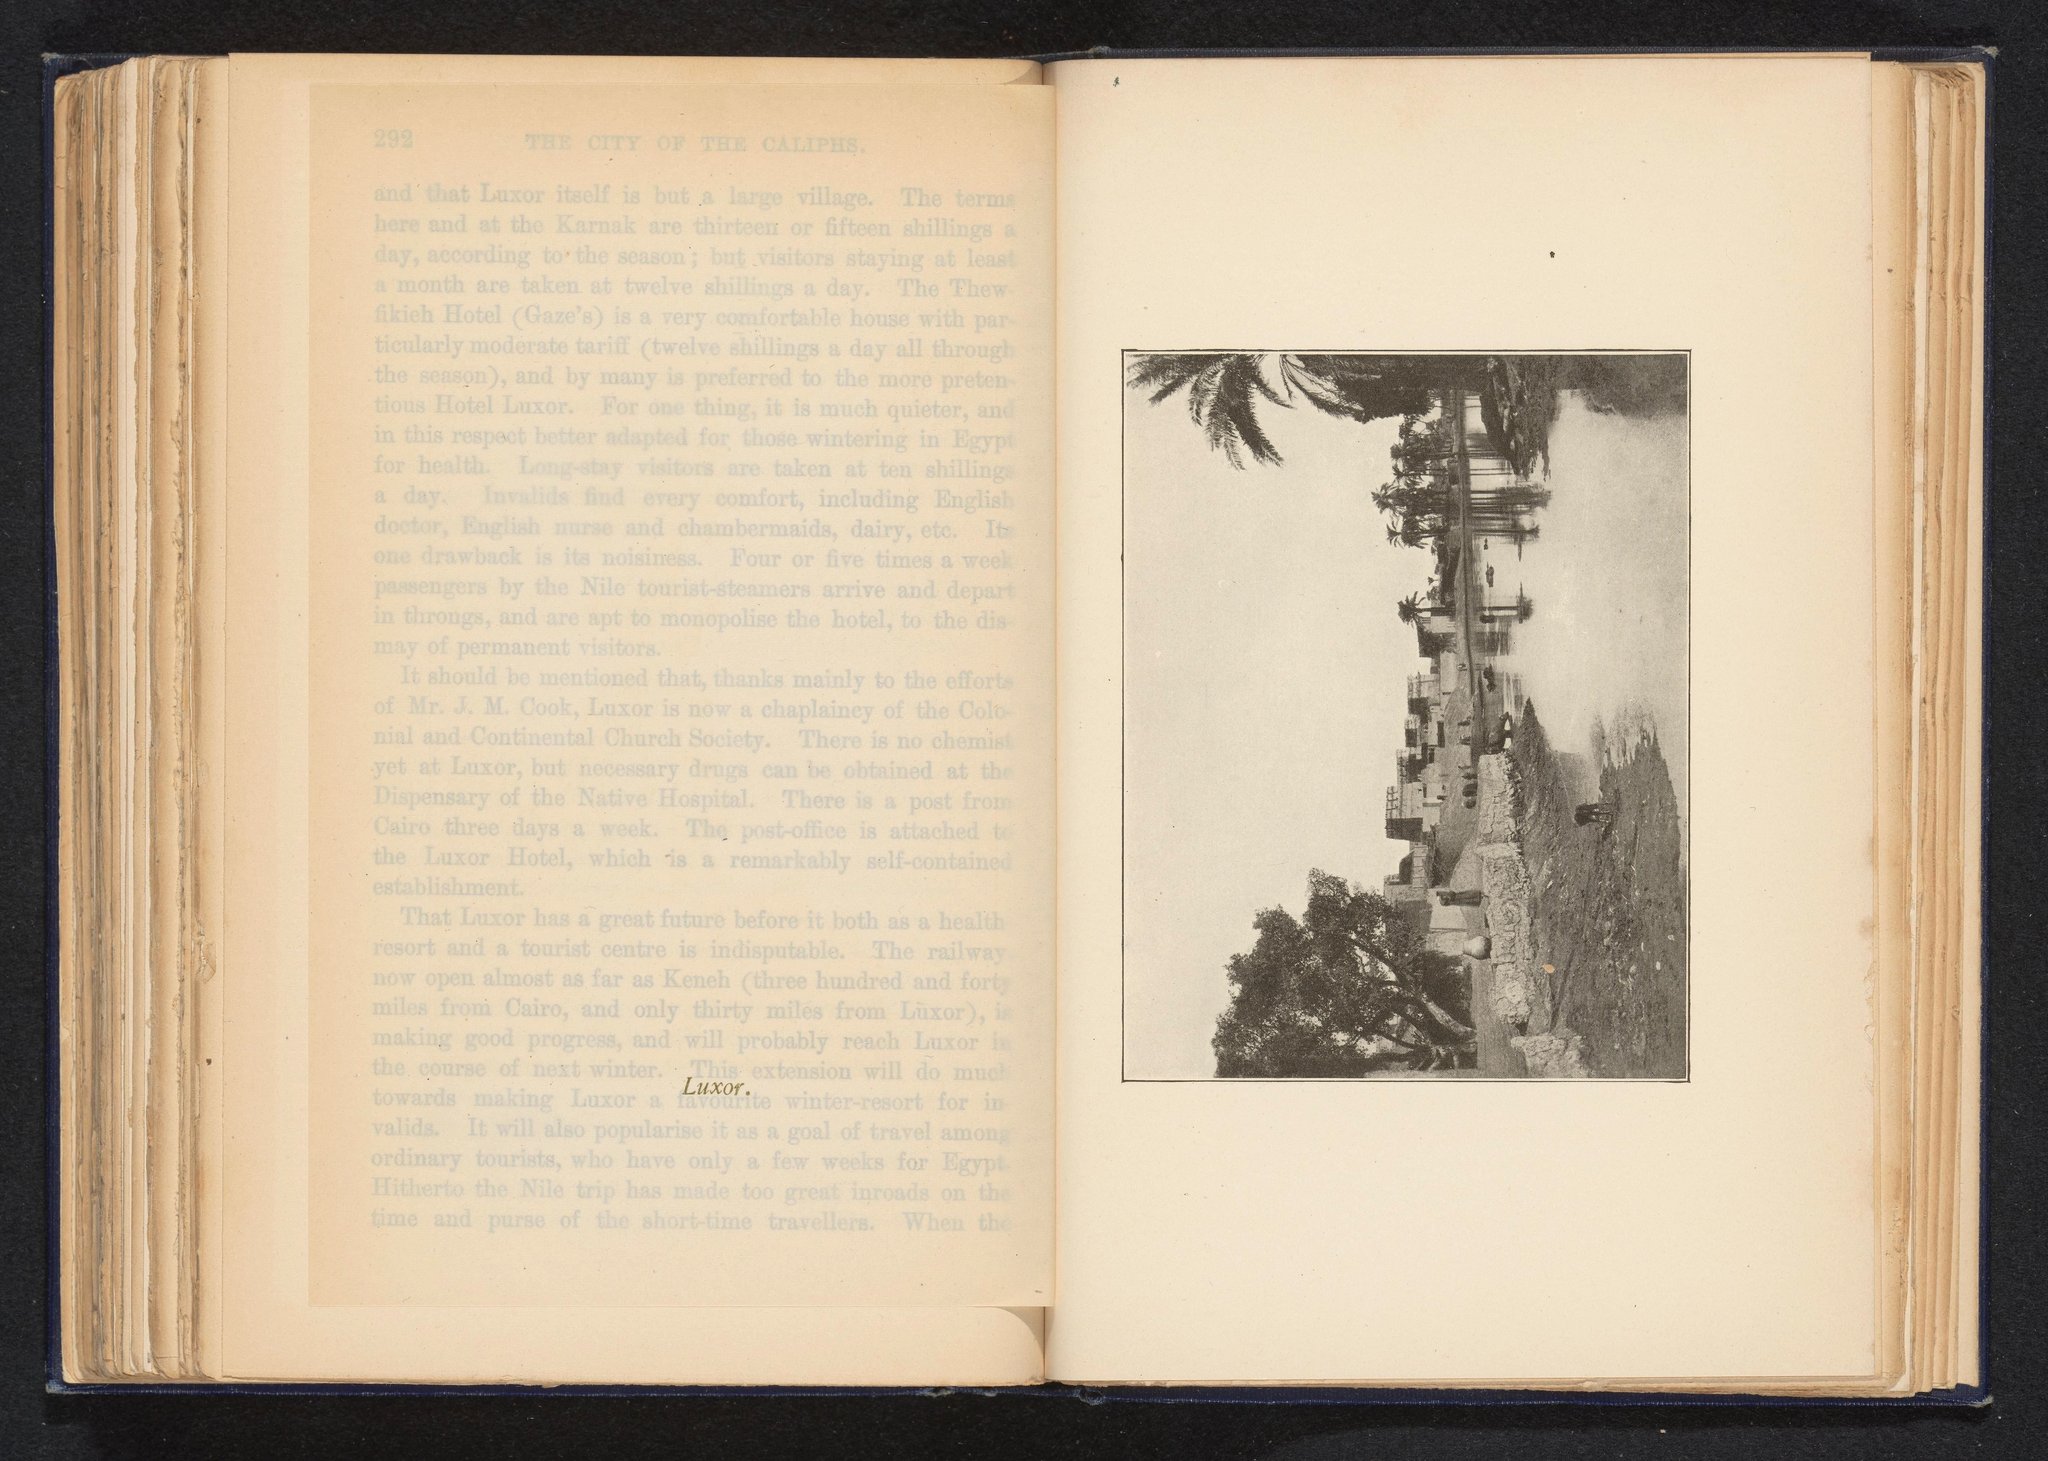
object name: page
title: Gezicht op Luxor en de Nijl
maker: Anonymous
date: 1891-1901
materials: paper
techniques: autotype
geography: luxor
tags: river, trees: palm-tree